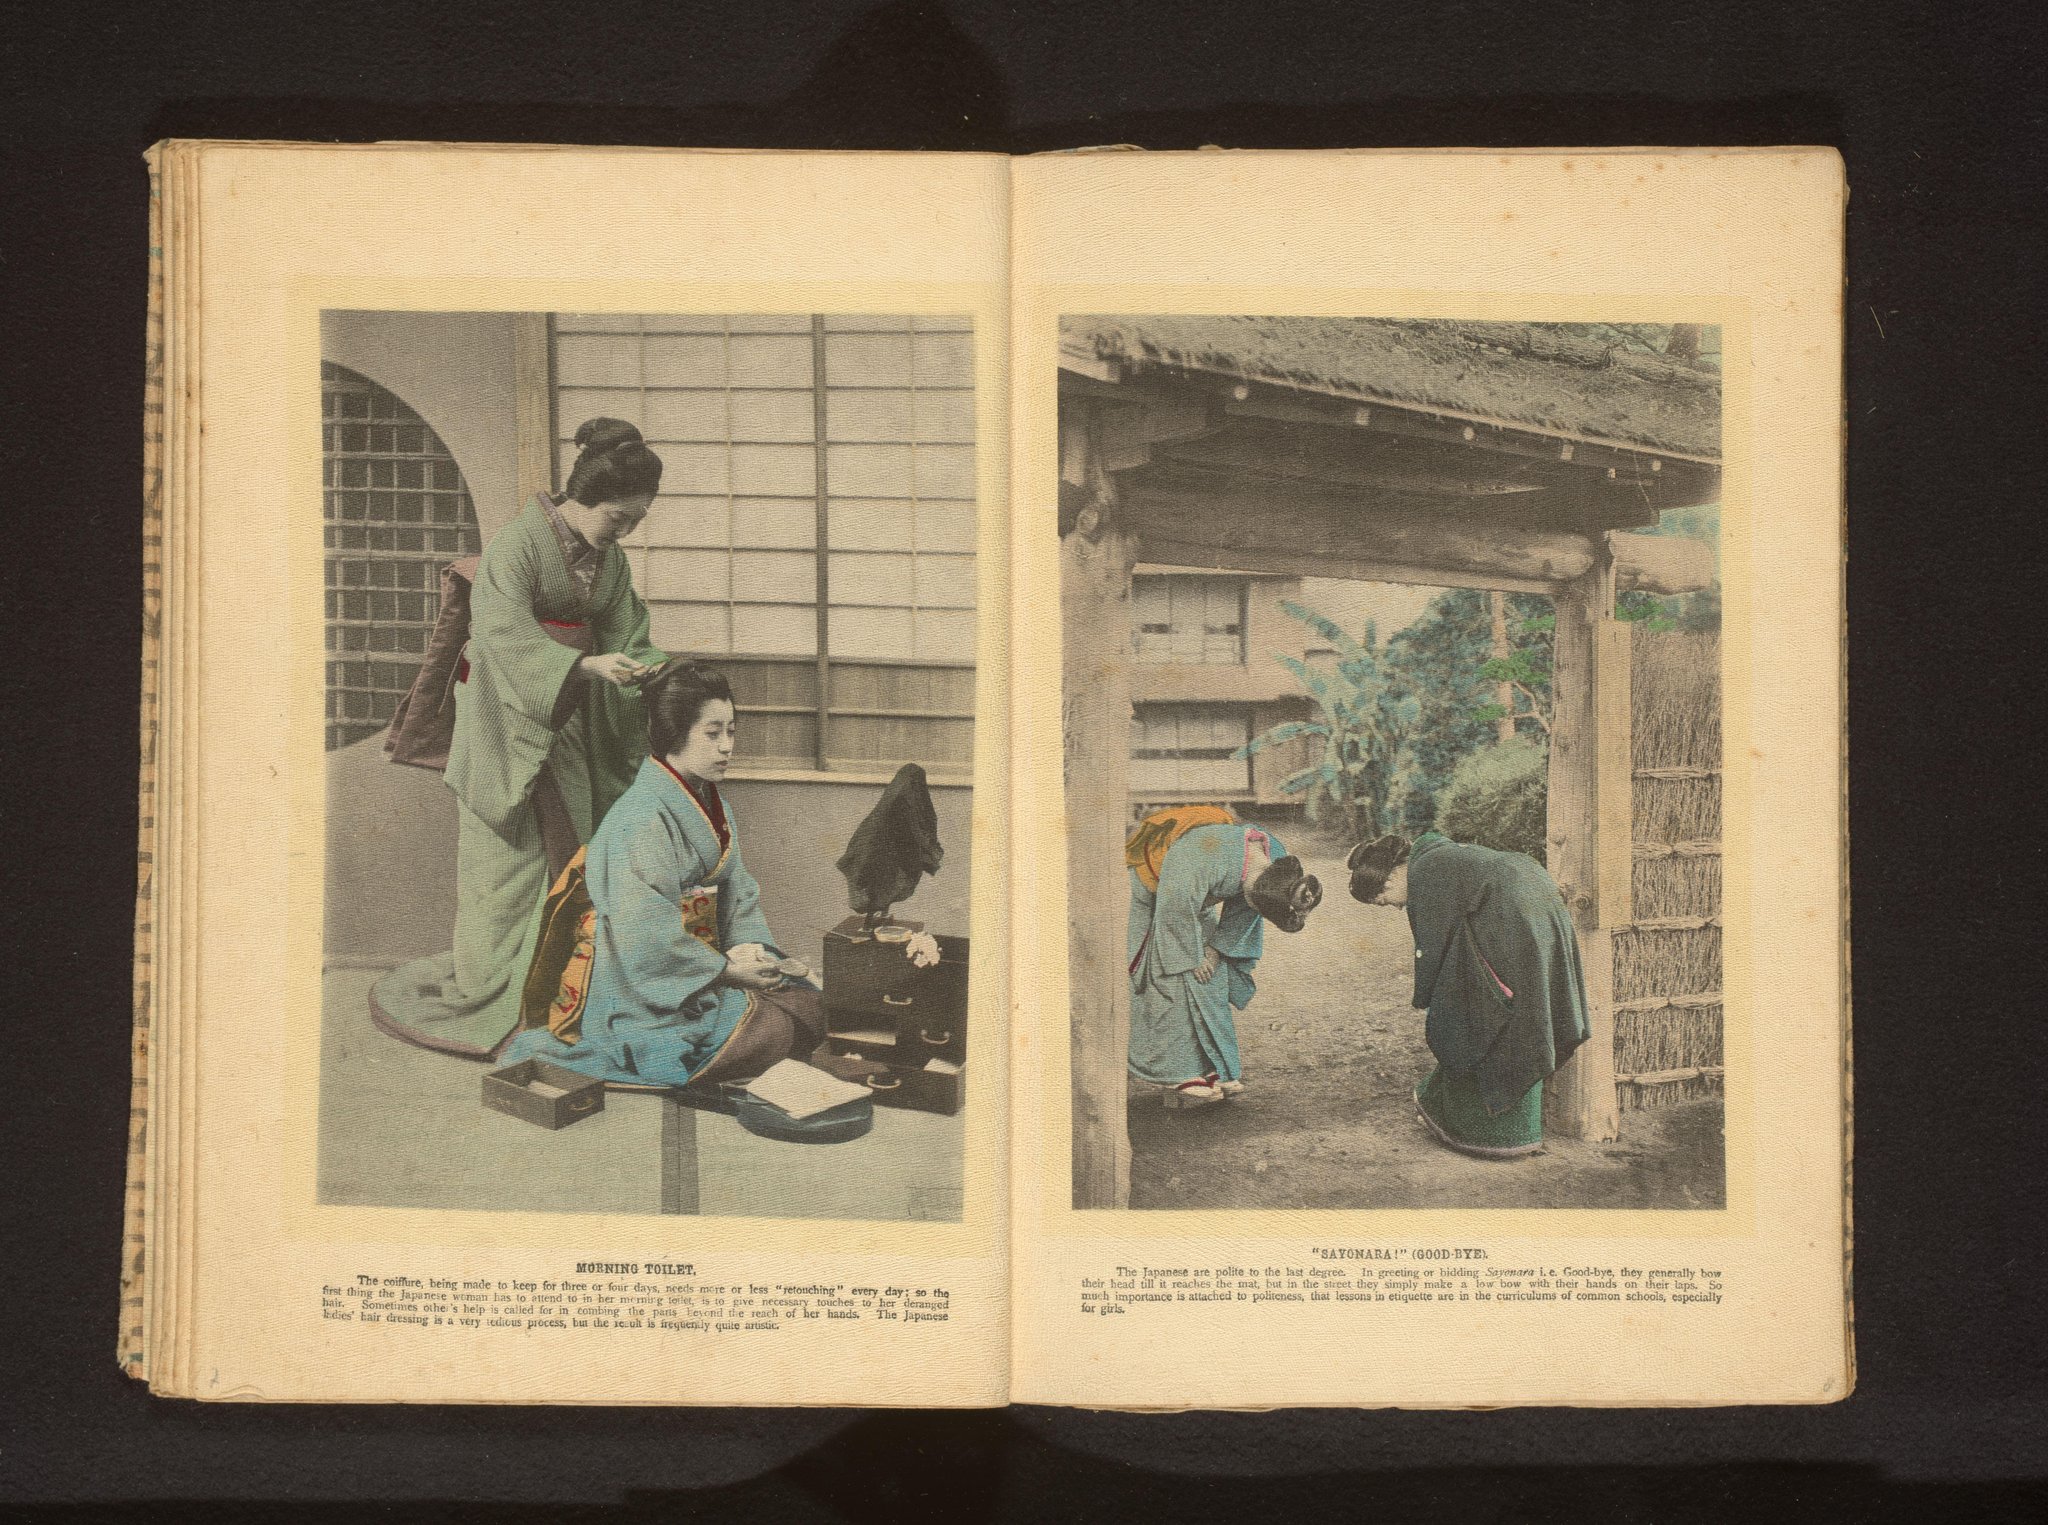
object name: photomechanical print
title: "Sayonara!" (good-bye)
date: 1886-1896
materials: paper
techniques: photograph, hand coloring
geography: japan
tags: head bent forward; bowing - aa - female human figure, adult woman, gate, entrance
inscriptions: inscription: ‘The Japanese (...) for girls.’